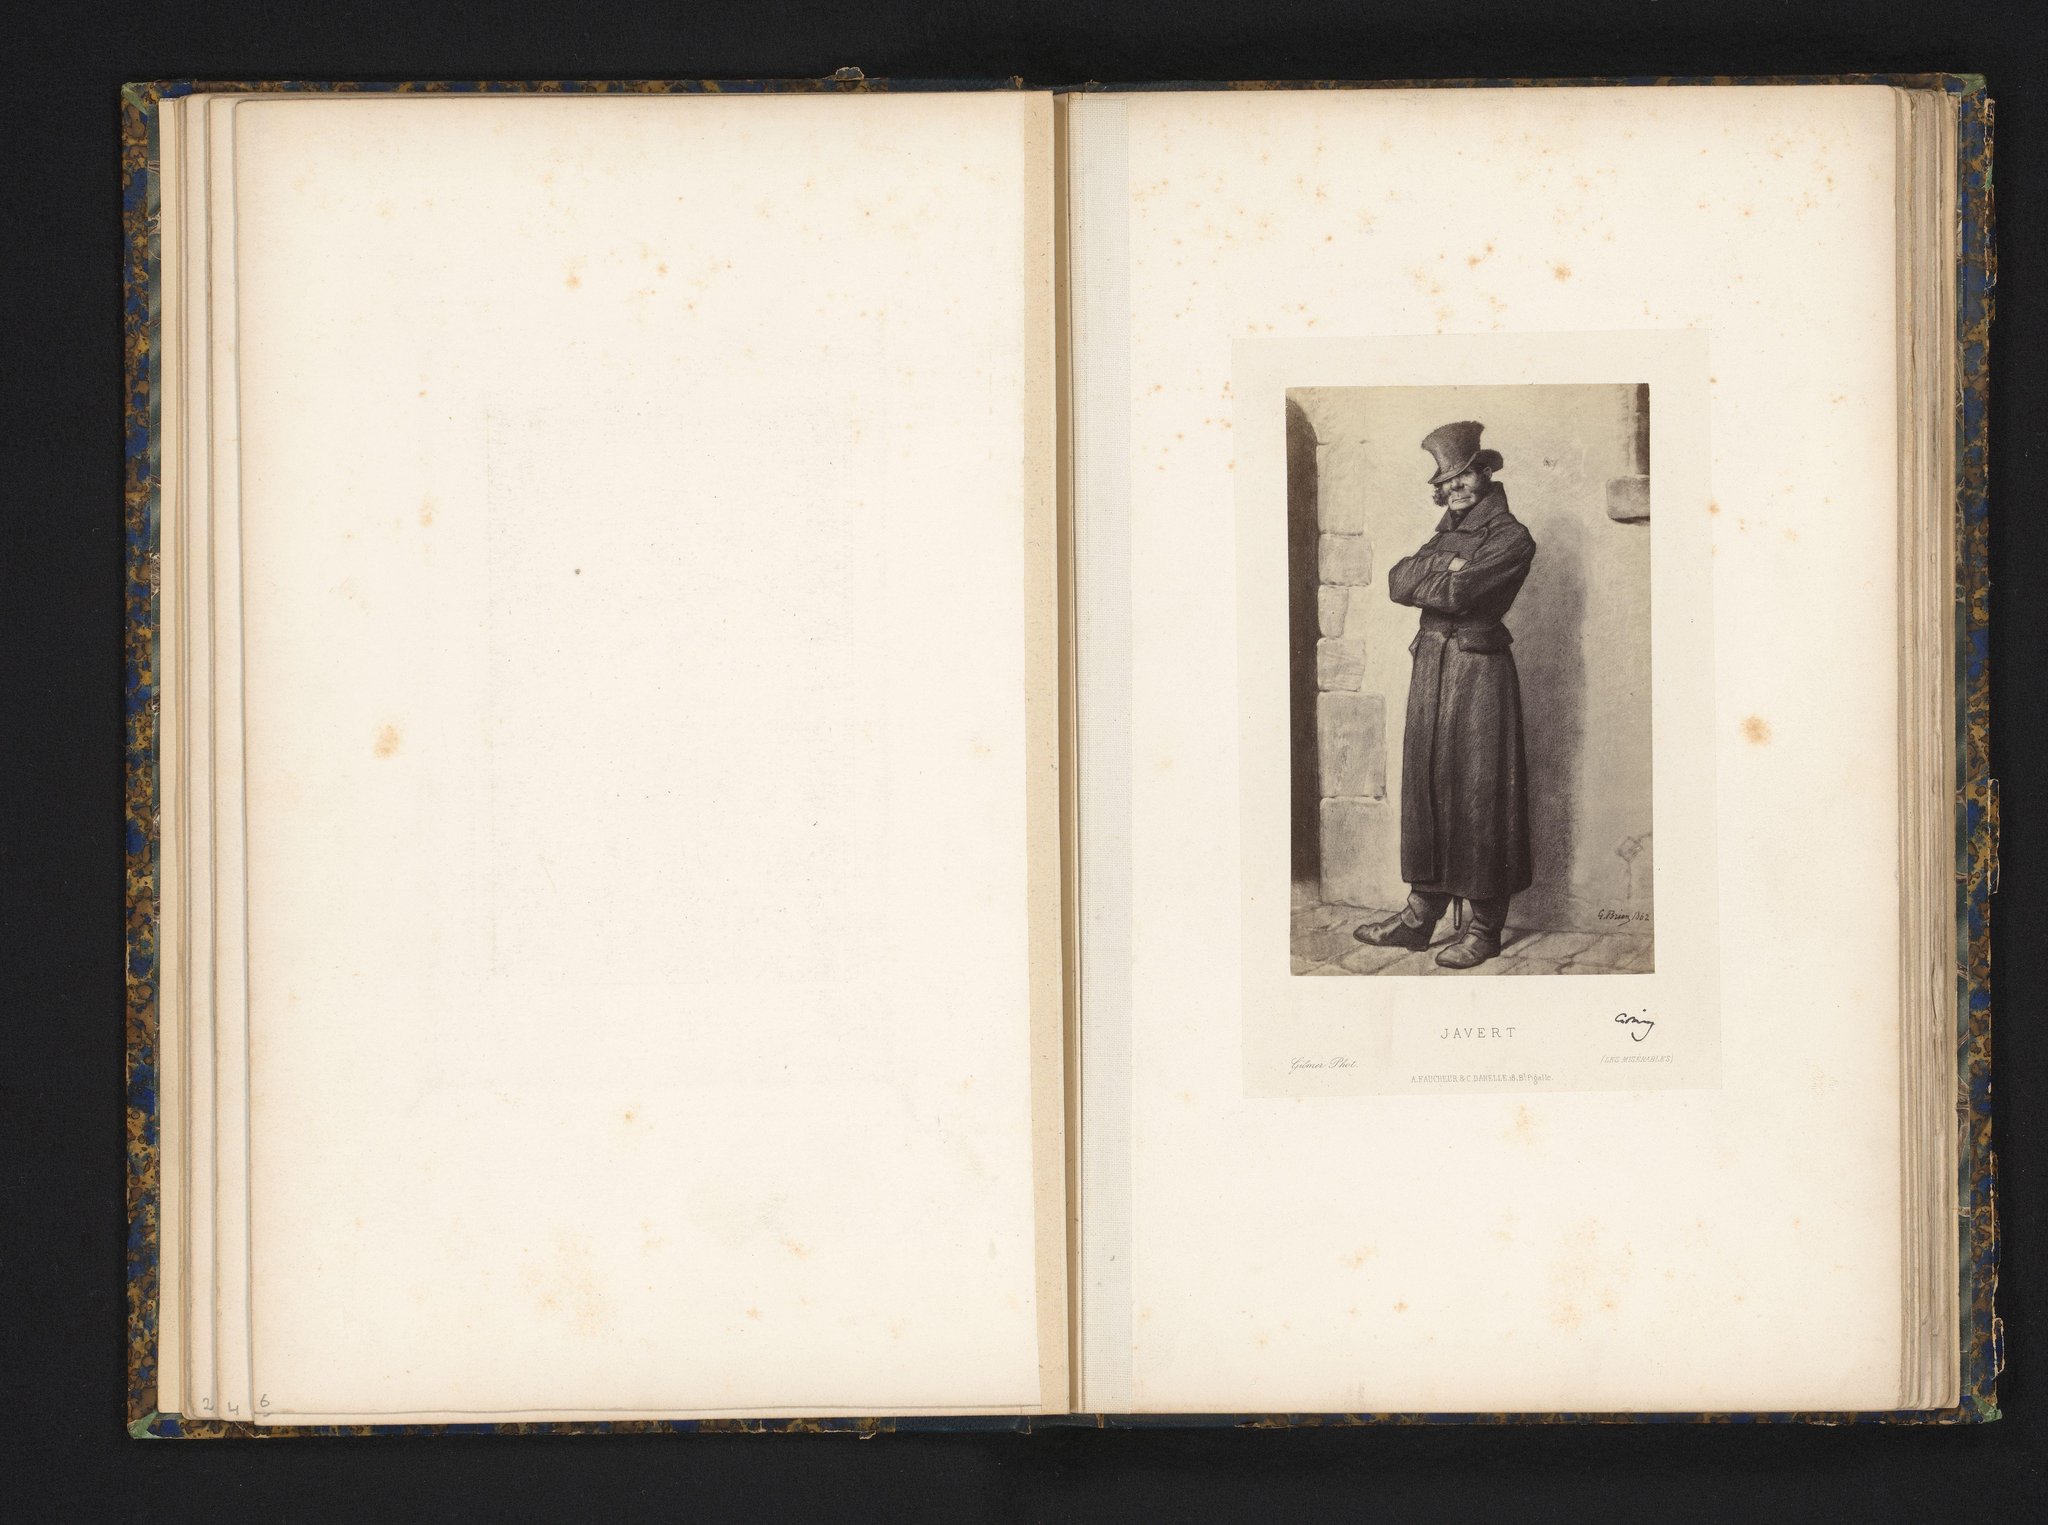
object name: reproduction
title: Javert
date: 1862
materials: photographic support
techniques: albumen print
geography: paris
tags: literary characters and objects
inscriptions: address: ‘A. FAUCHEUR & C. DANELLE 18, Bt. Pigalle.’, inscription: ‘(LES MISÉRABLES)’